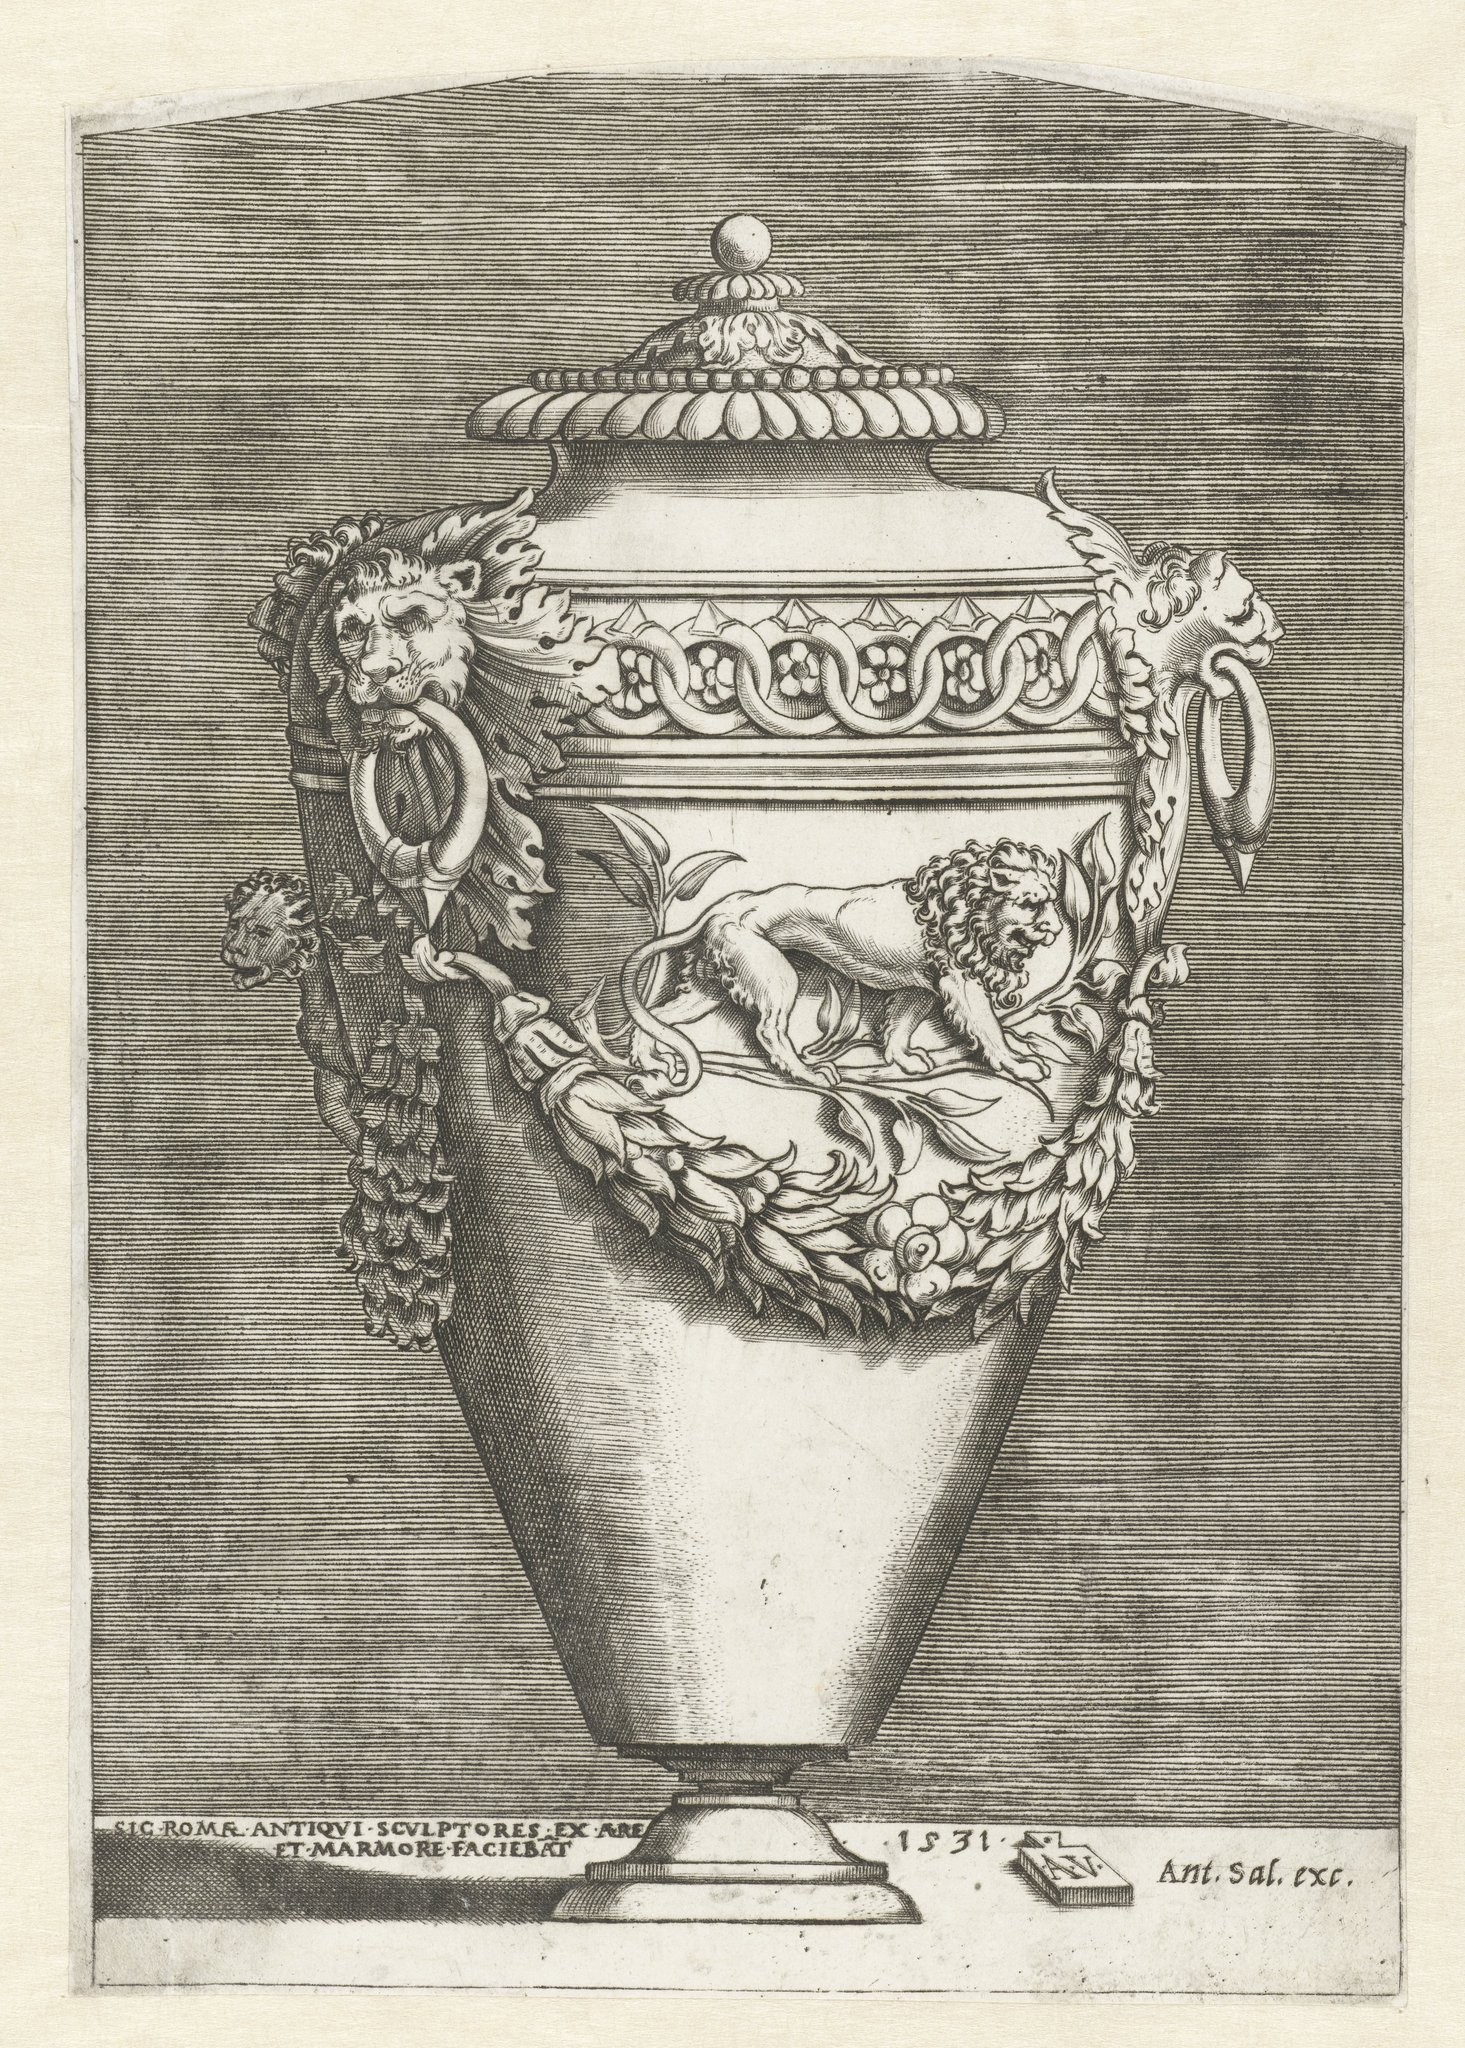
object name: print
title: Vazen en kannen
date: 1500-1531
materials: paper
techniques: engraving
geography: italy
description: De buik van de vaas is gedecoreerd met een guirlande waarboven een leeuw op een tak staat. Uit serie van 12 bladen. Blad uit tweede editie van serie.